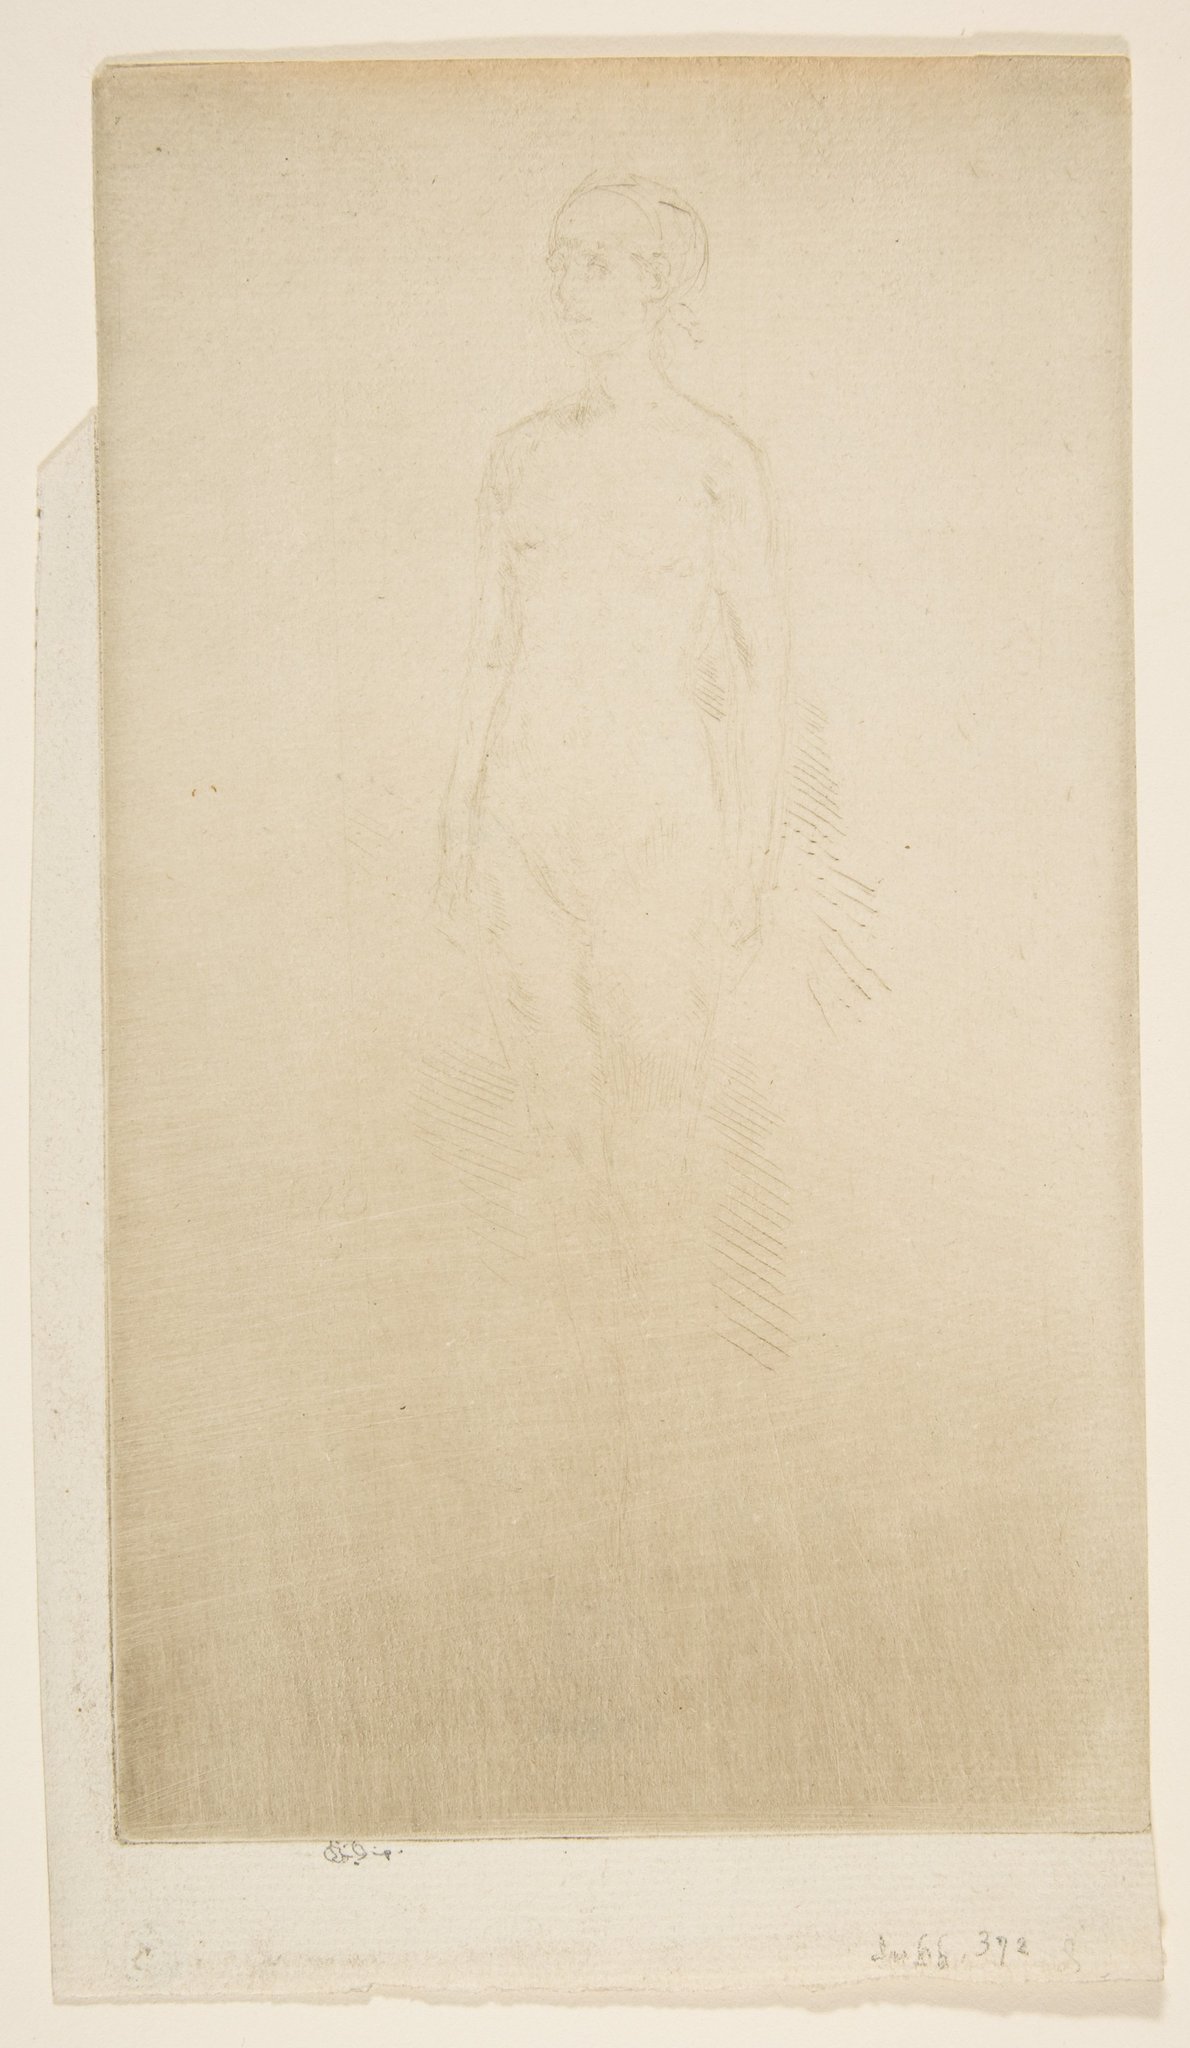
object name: print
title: Nude Woman Standing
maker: james mcneill whistler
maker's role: artist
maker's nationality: american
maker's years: 1834-1903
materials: ink, paper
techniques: drypoint, printing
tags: female nudes